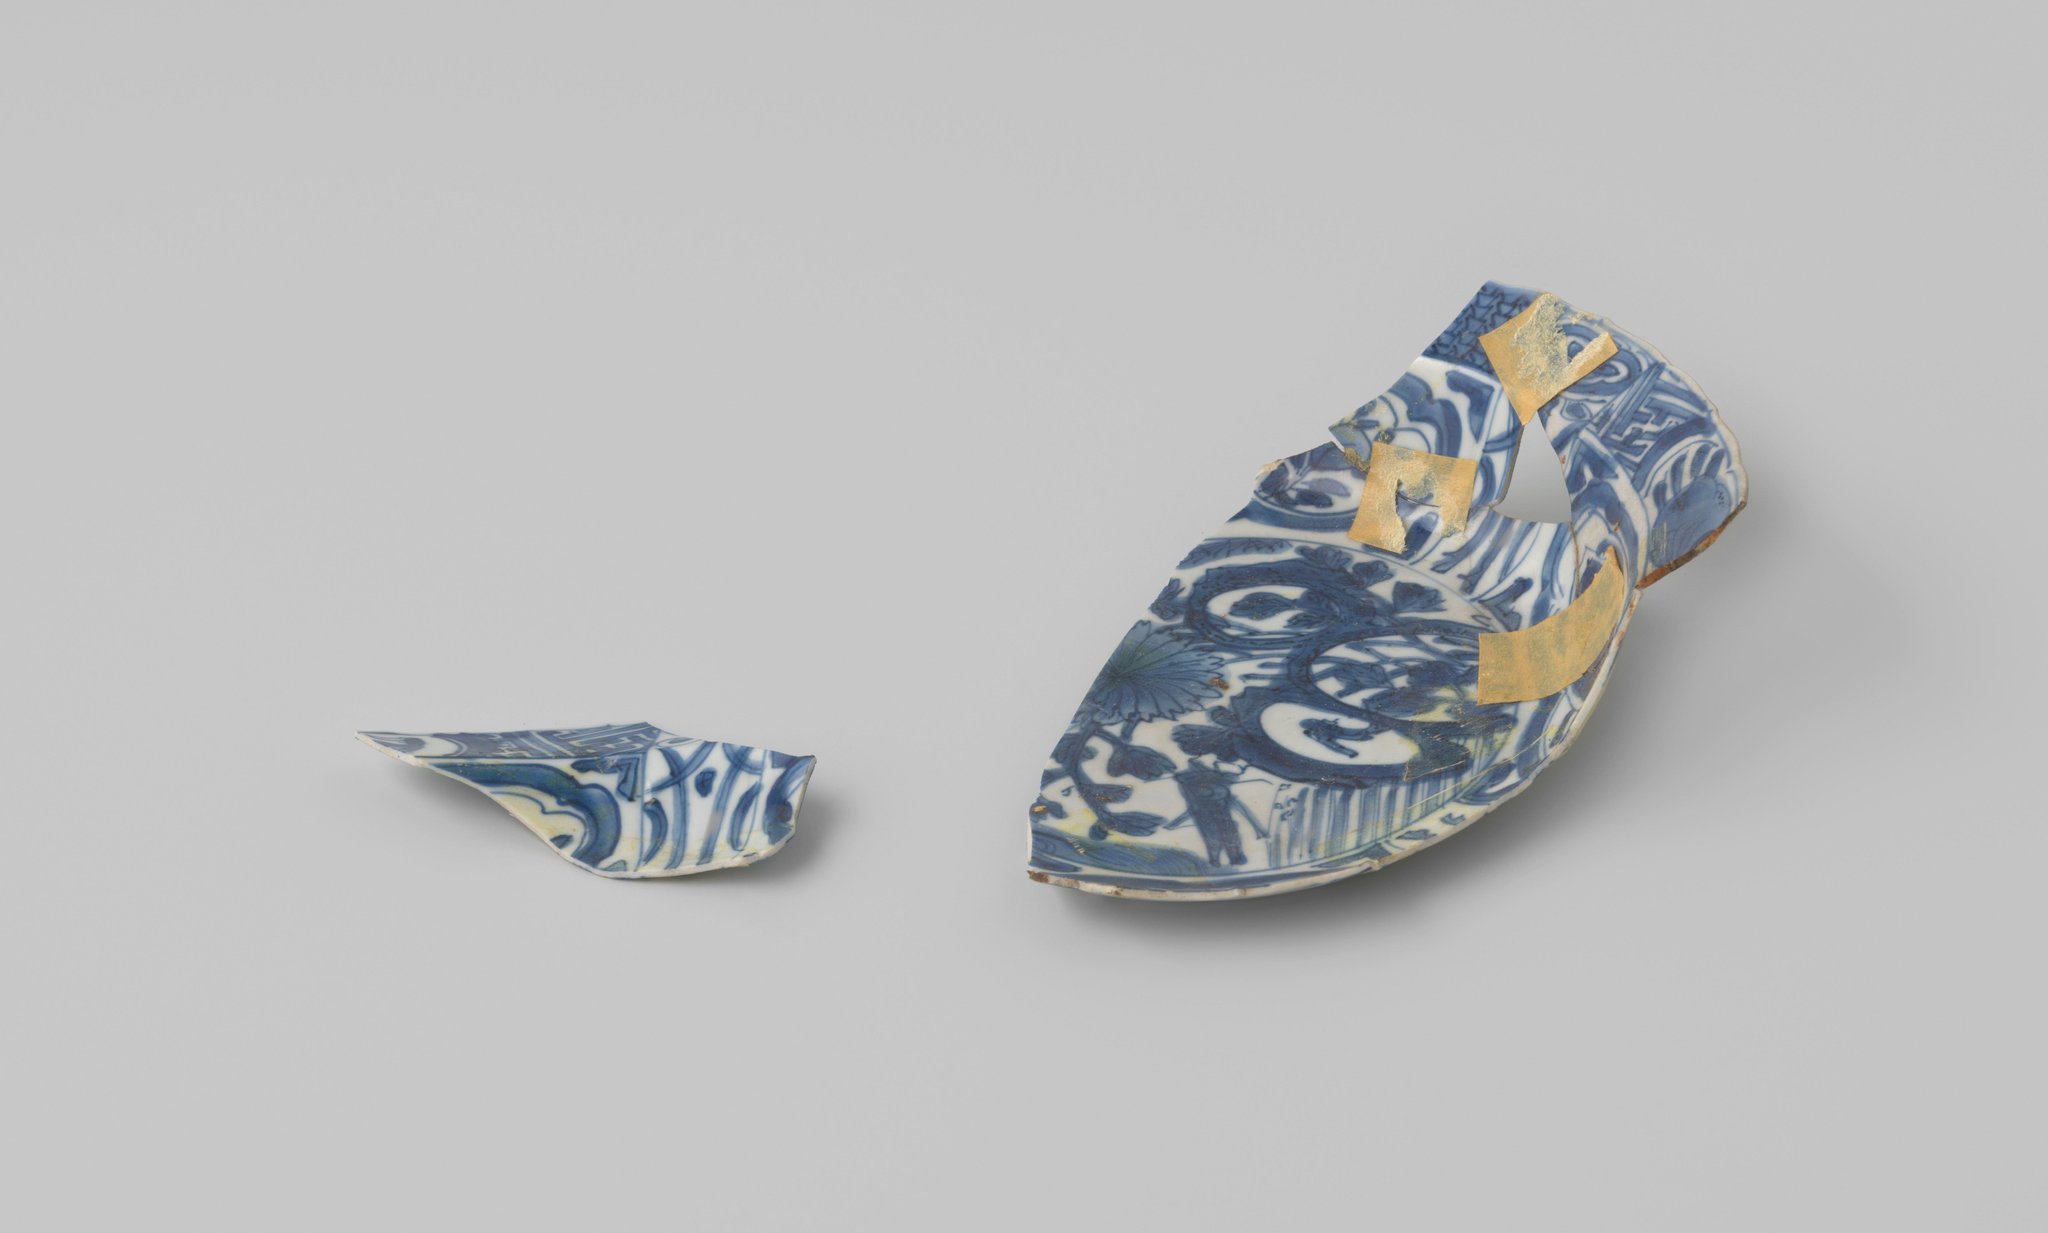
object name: sherd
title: Scherven van diep bord uit V.O.C.-schip de 'Witte Leeuw'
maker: Anonymous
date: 1613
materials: bone china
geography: jingdezhen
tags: verenigde oostindische compagnie, sint-helena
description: Scherven van diep bord uit V.O.C.-schip de 'Witte Leeuw'.